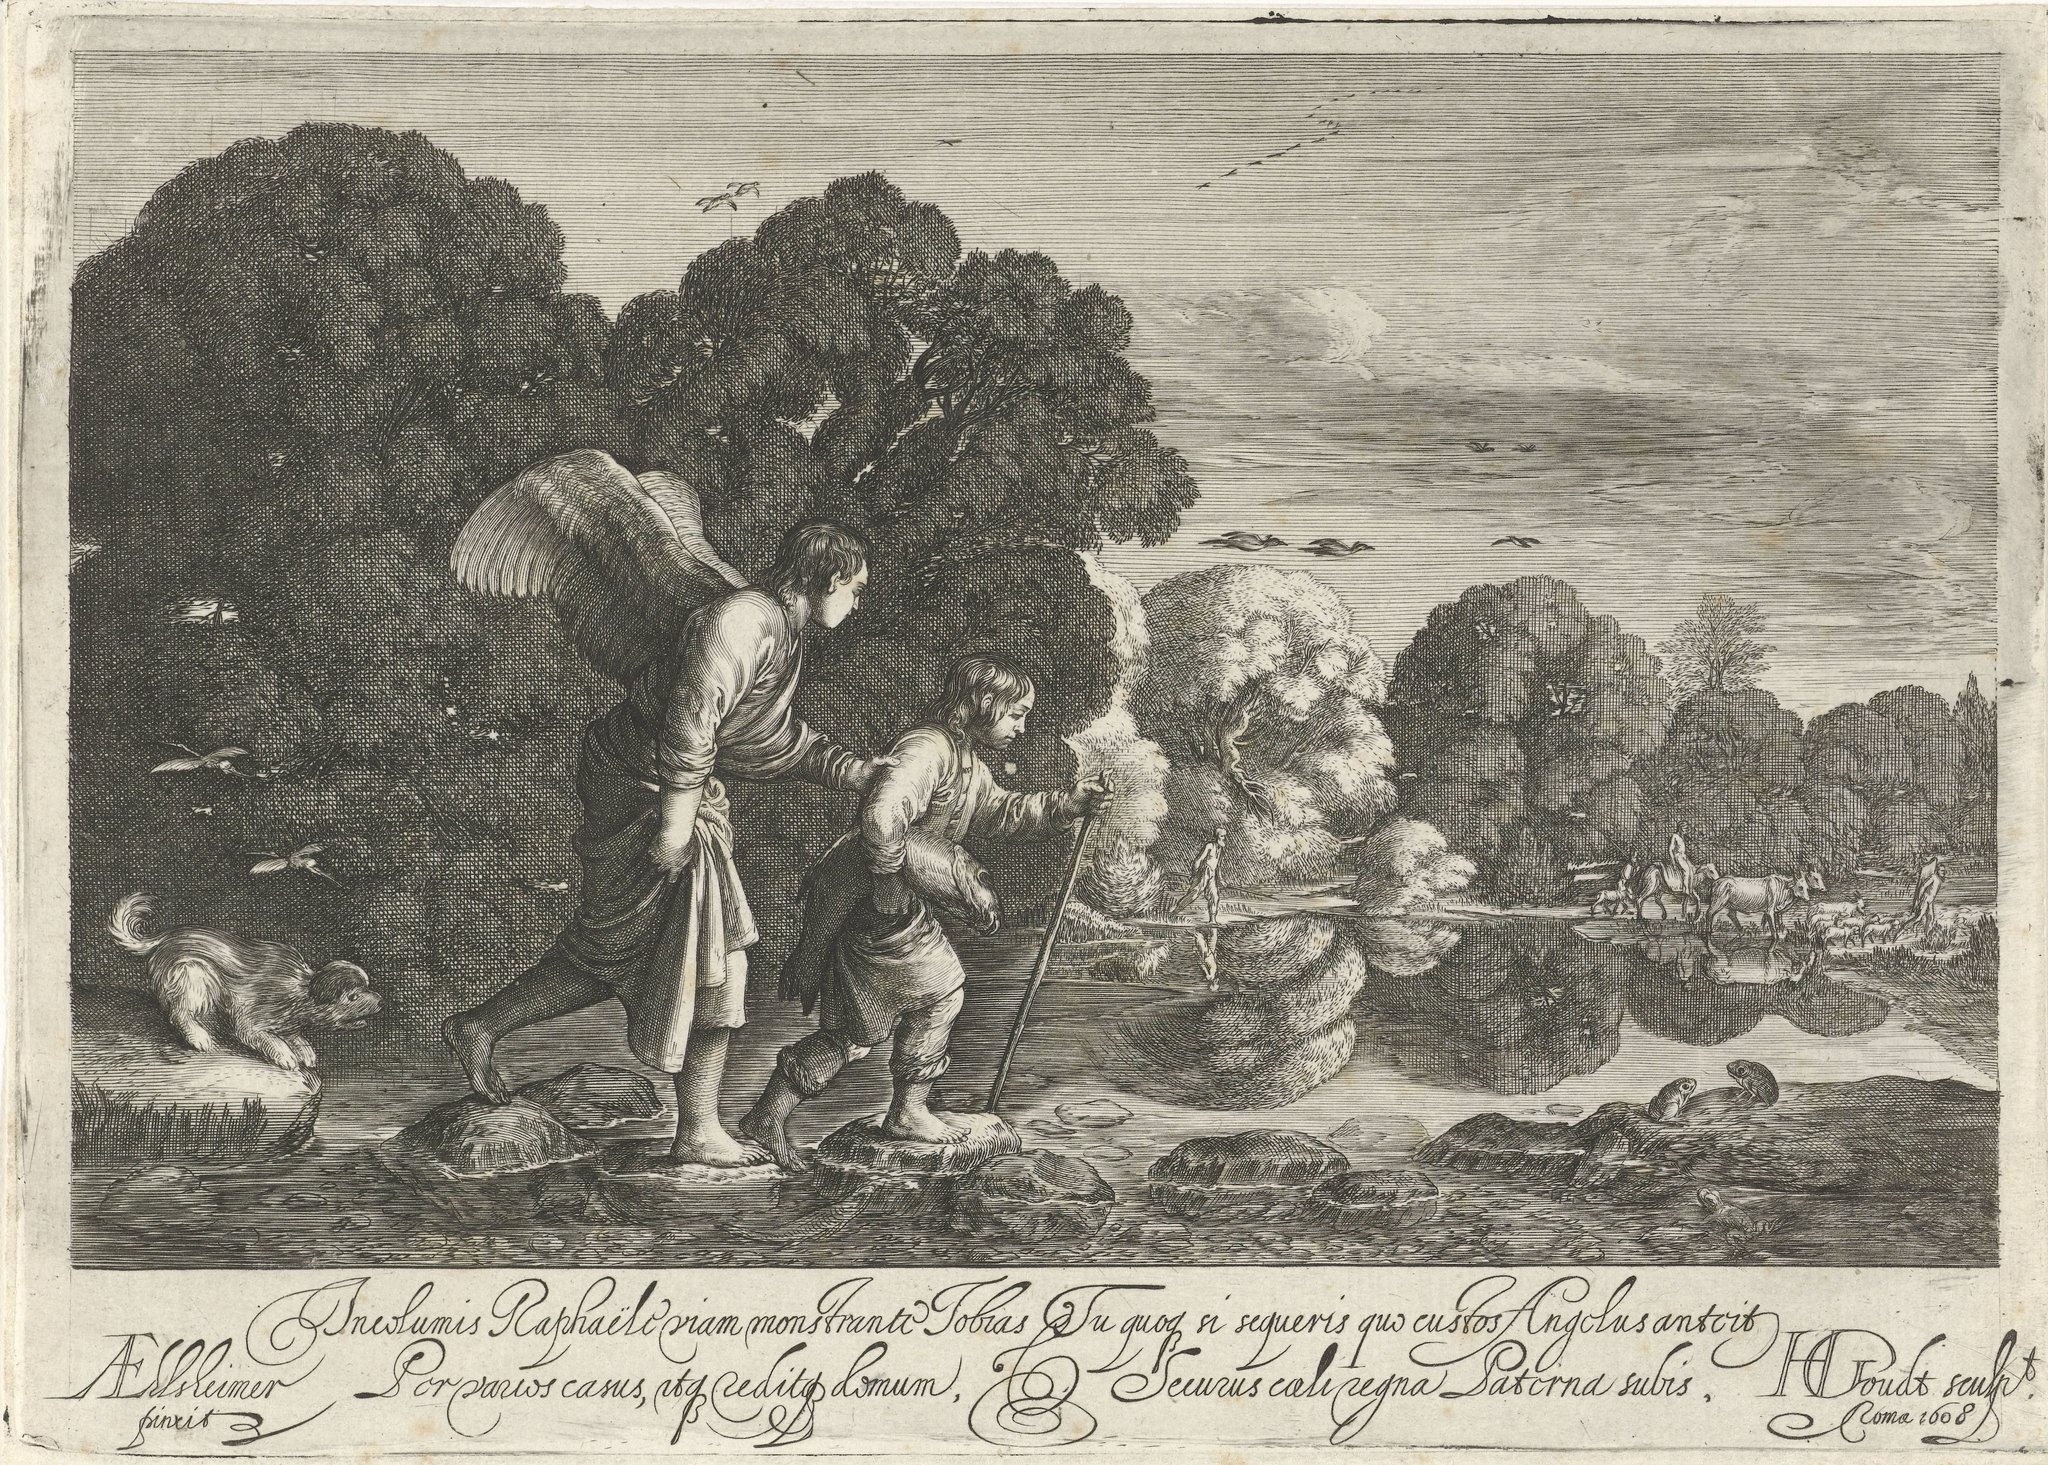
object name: print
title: Tobias en de engel bij een rivier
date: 1608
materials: paper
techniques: engraving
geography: rome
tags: tobias and the angel raphael travelling, accompanied by tobias' dog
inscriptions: collector's mark: Lugt 11, collector's mark: Lugt 10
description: Tobias en de engel Rafaël steken een rivier over. Een hond volgt hen. In Tobias' handen een grote vis. Tobias zal de vis zijn gal later gebruiken om zijn vaders blindheid te genezen. Op de achtergrond een herder en zijn kudde. De prent heeft een Latijns onderschrift. Naar een schilderij van Adam Elsheimer